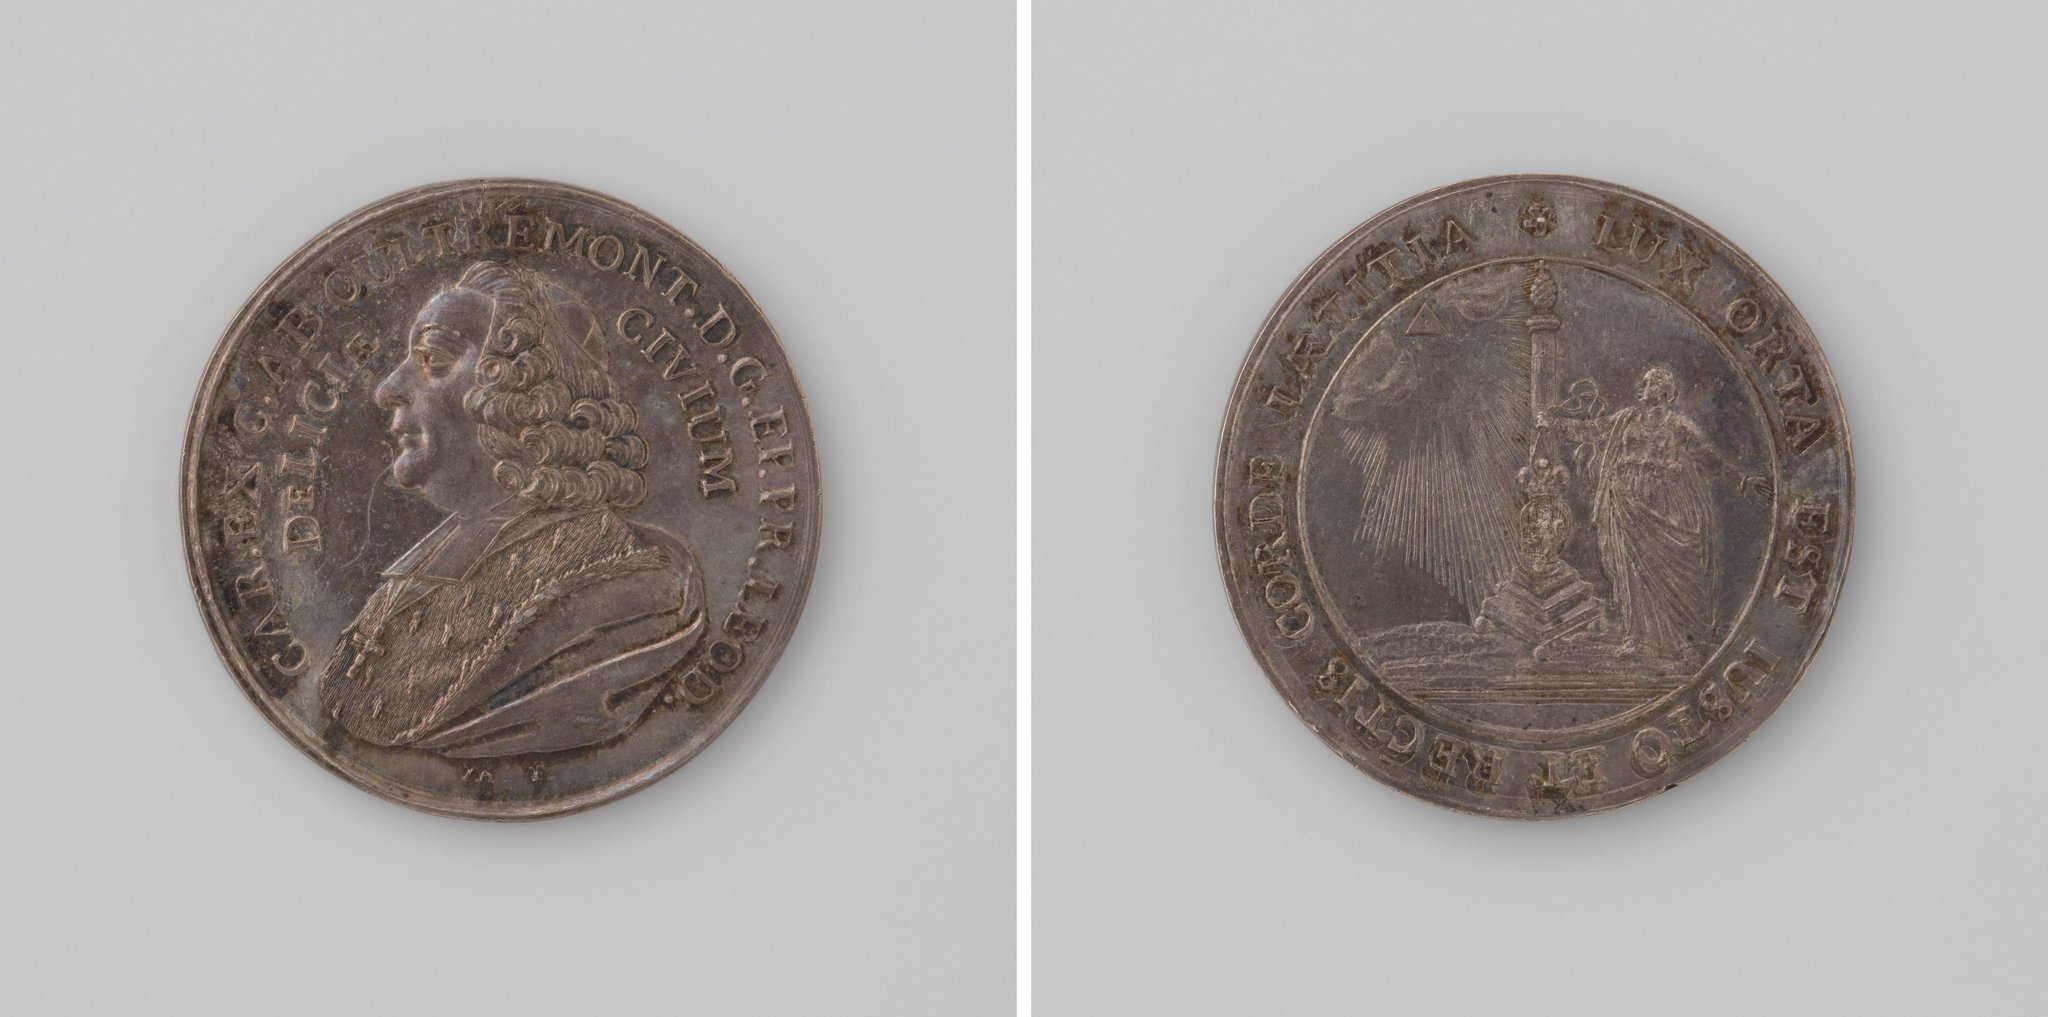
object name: history medal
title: Karel, graaf d'Oultremont, prins-bisschop van Luik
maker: philippe joseph jacoby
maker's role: graveur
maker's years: 1708-1794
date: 1764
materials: silver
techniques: striking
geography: liège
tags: liège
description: Zilveren penning. Voorzijde: borststuk man binnen tweeregelig omschrift. Keerzijde: vrouw hangt gekroond wapenschild aan zuil, beschenen door stralende driehoek binnen omschrift